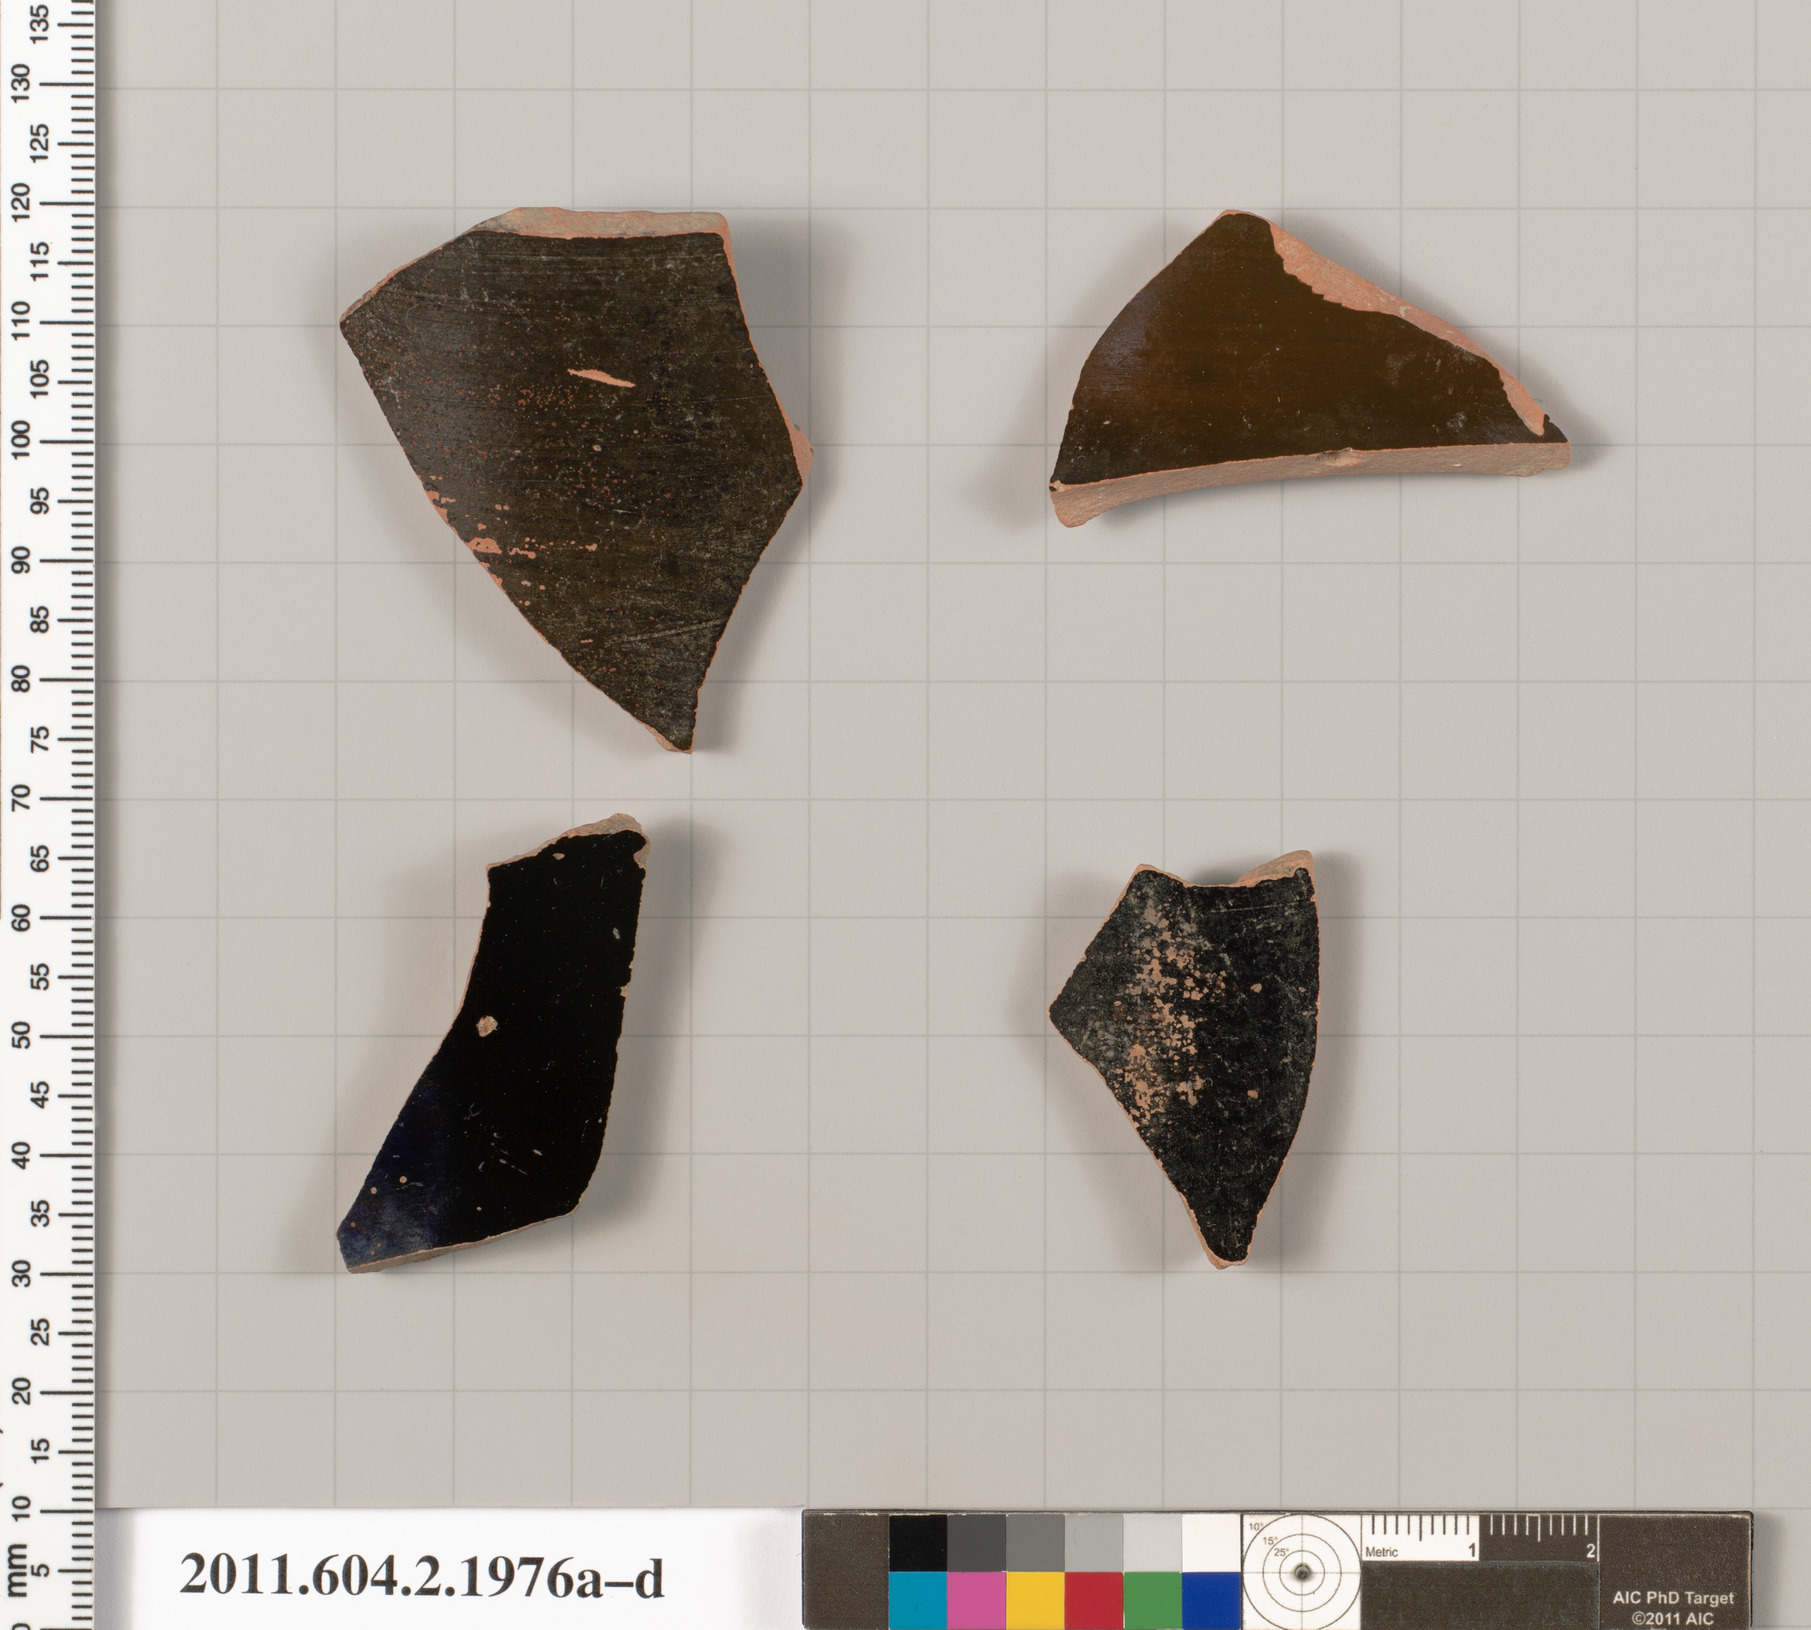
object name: neck amphora fragment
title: Terracotta fragments of Nolan neck-amphorae (jars)?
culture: greek, attic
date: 475-451 BCE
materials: terracotta